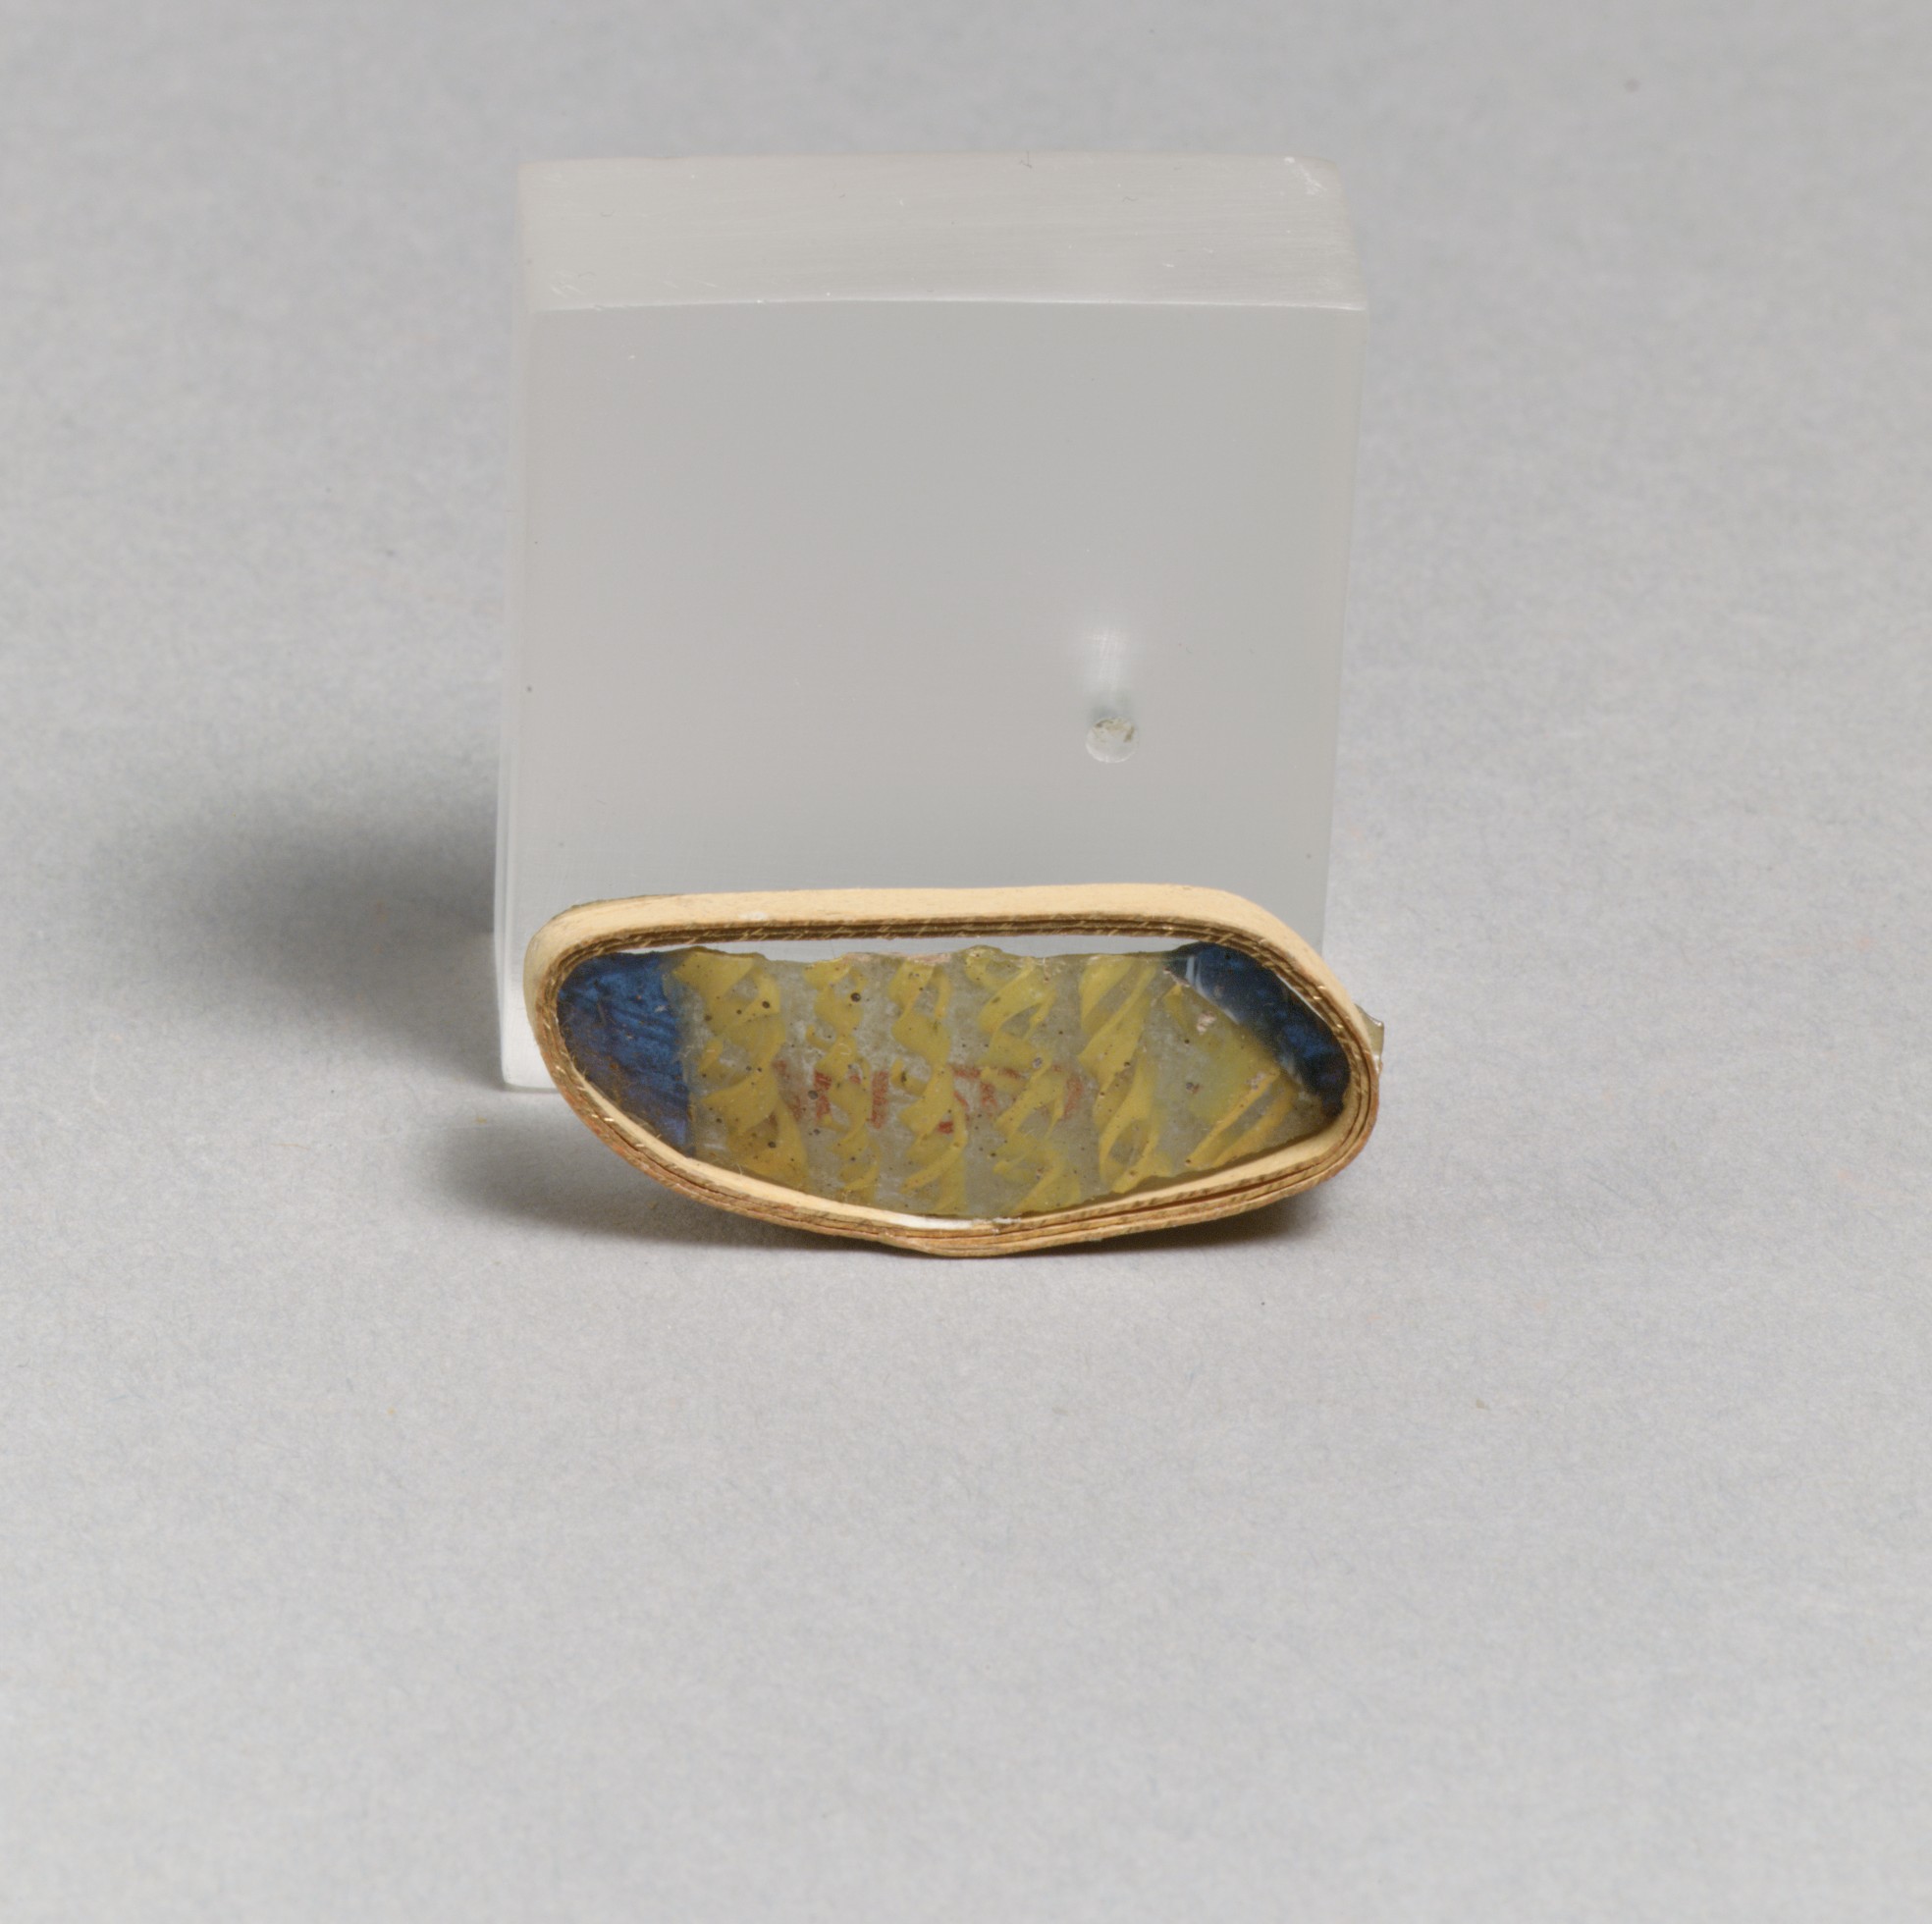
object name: fragment, network mosaic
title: Glass network mosaic bowl fragment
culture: roman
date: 34 BCE-33 CE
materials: glass